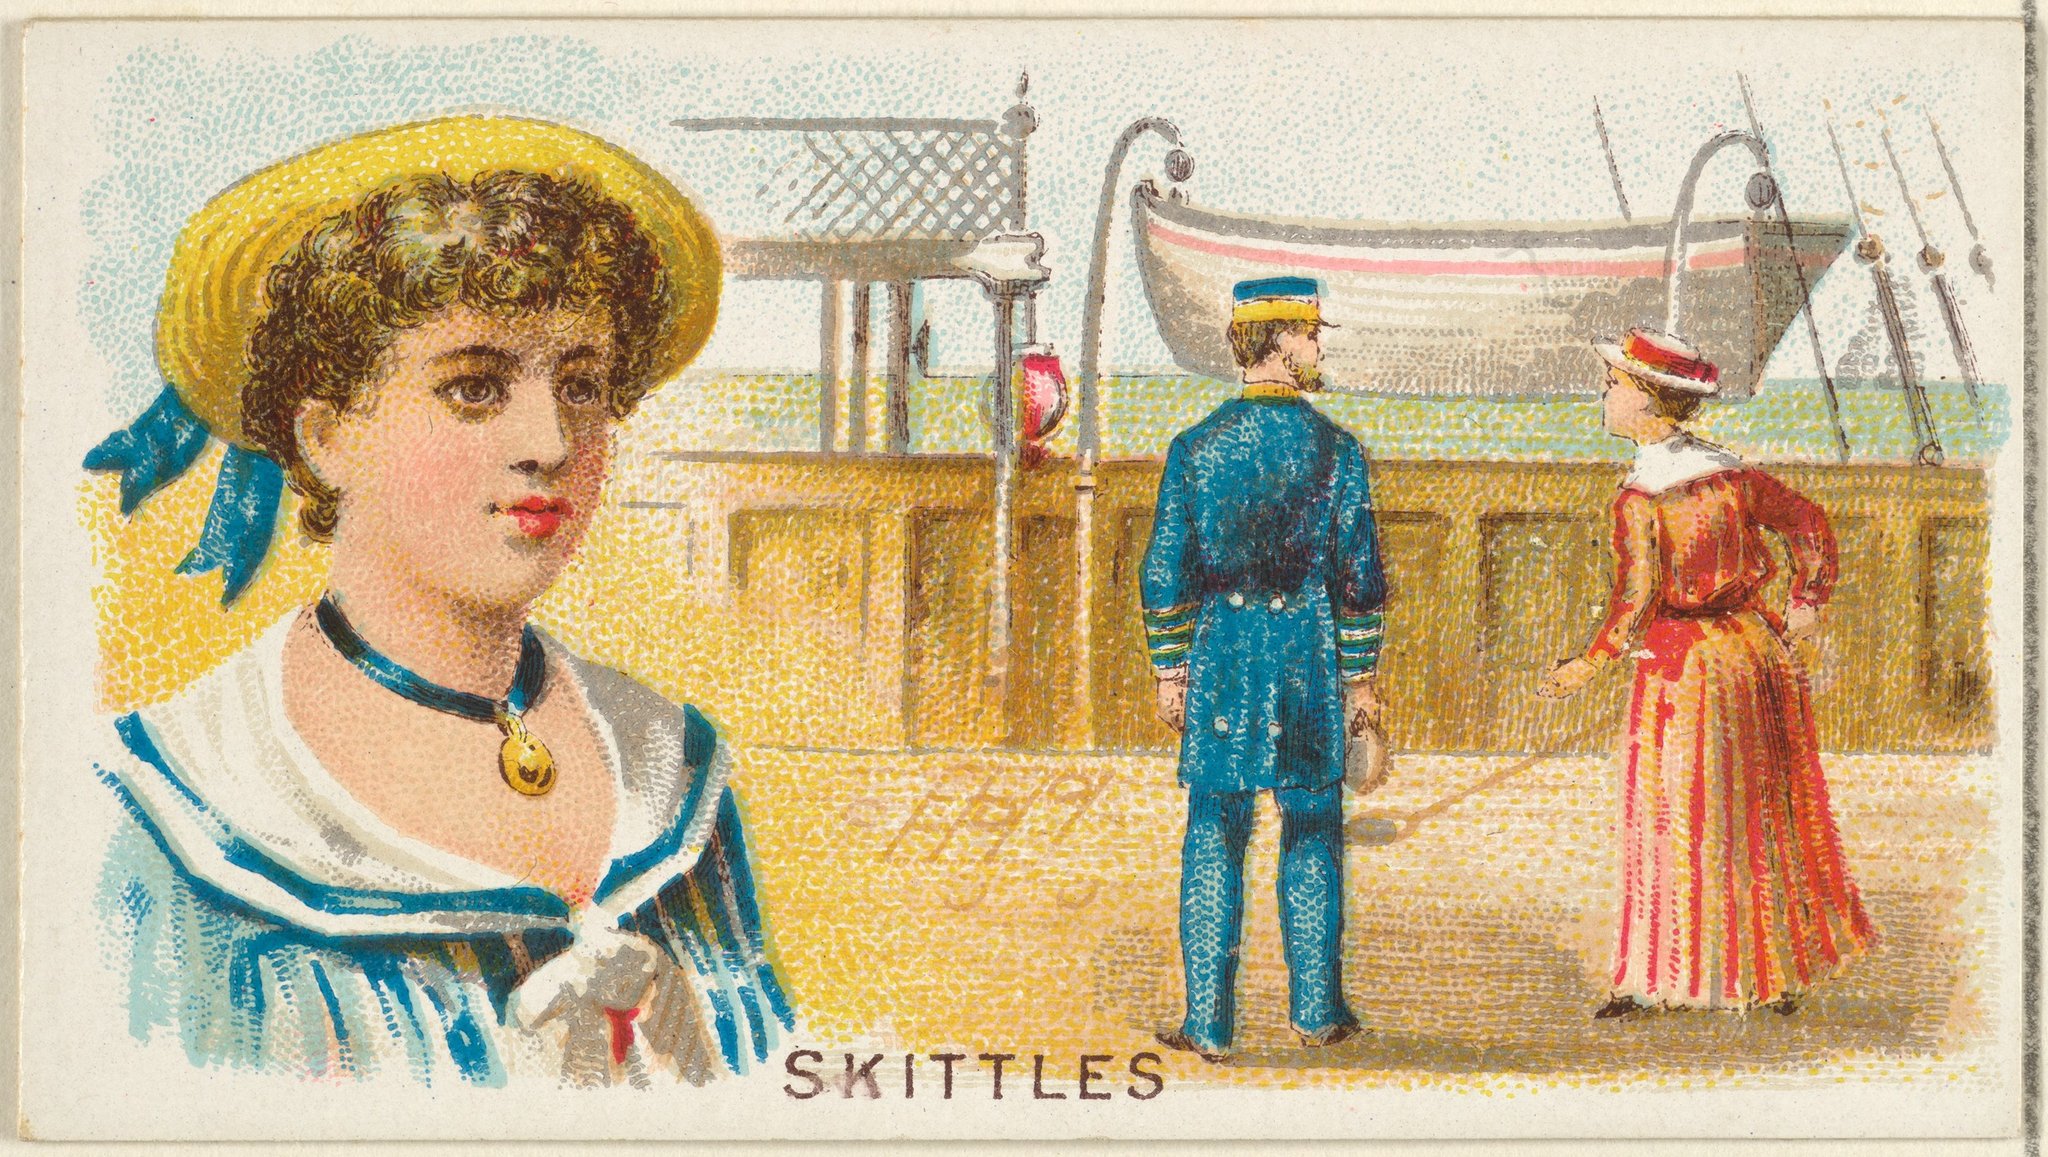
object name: print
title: Skittles, from the Games and Sports series (N165) for Old Judge Cigarettes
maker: goodwin & company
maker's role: publisher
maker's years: 1850-1950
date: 1889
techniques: color lithograph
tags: men,women,games